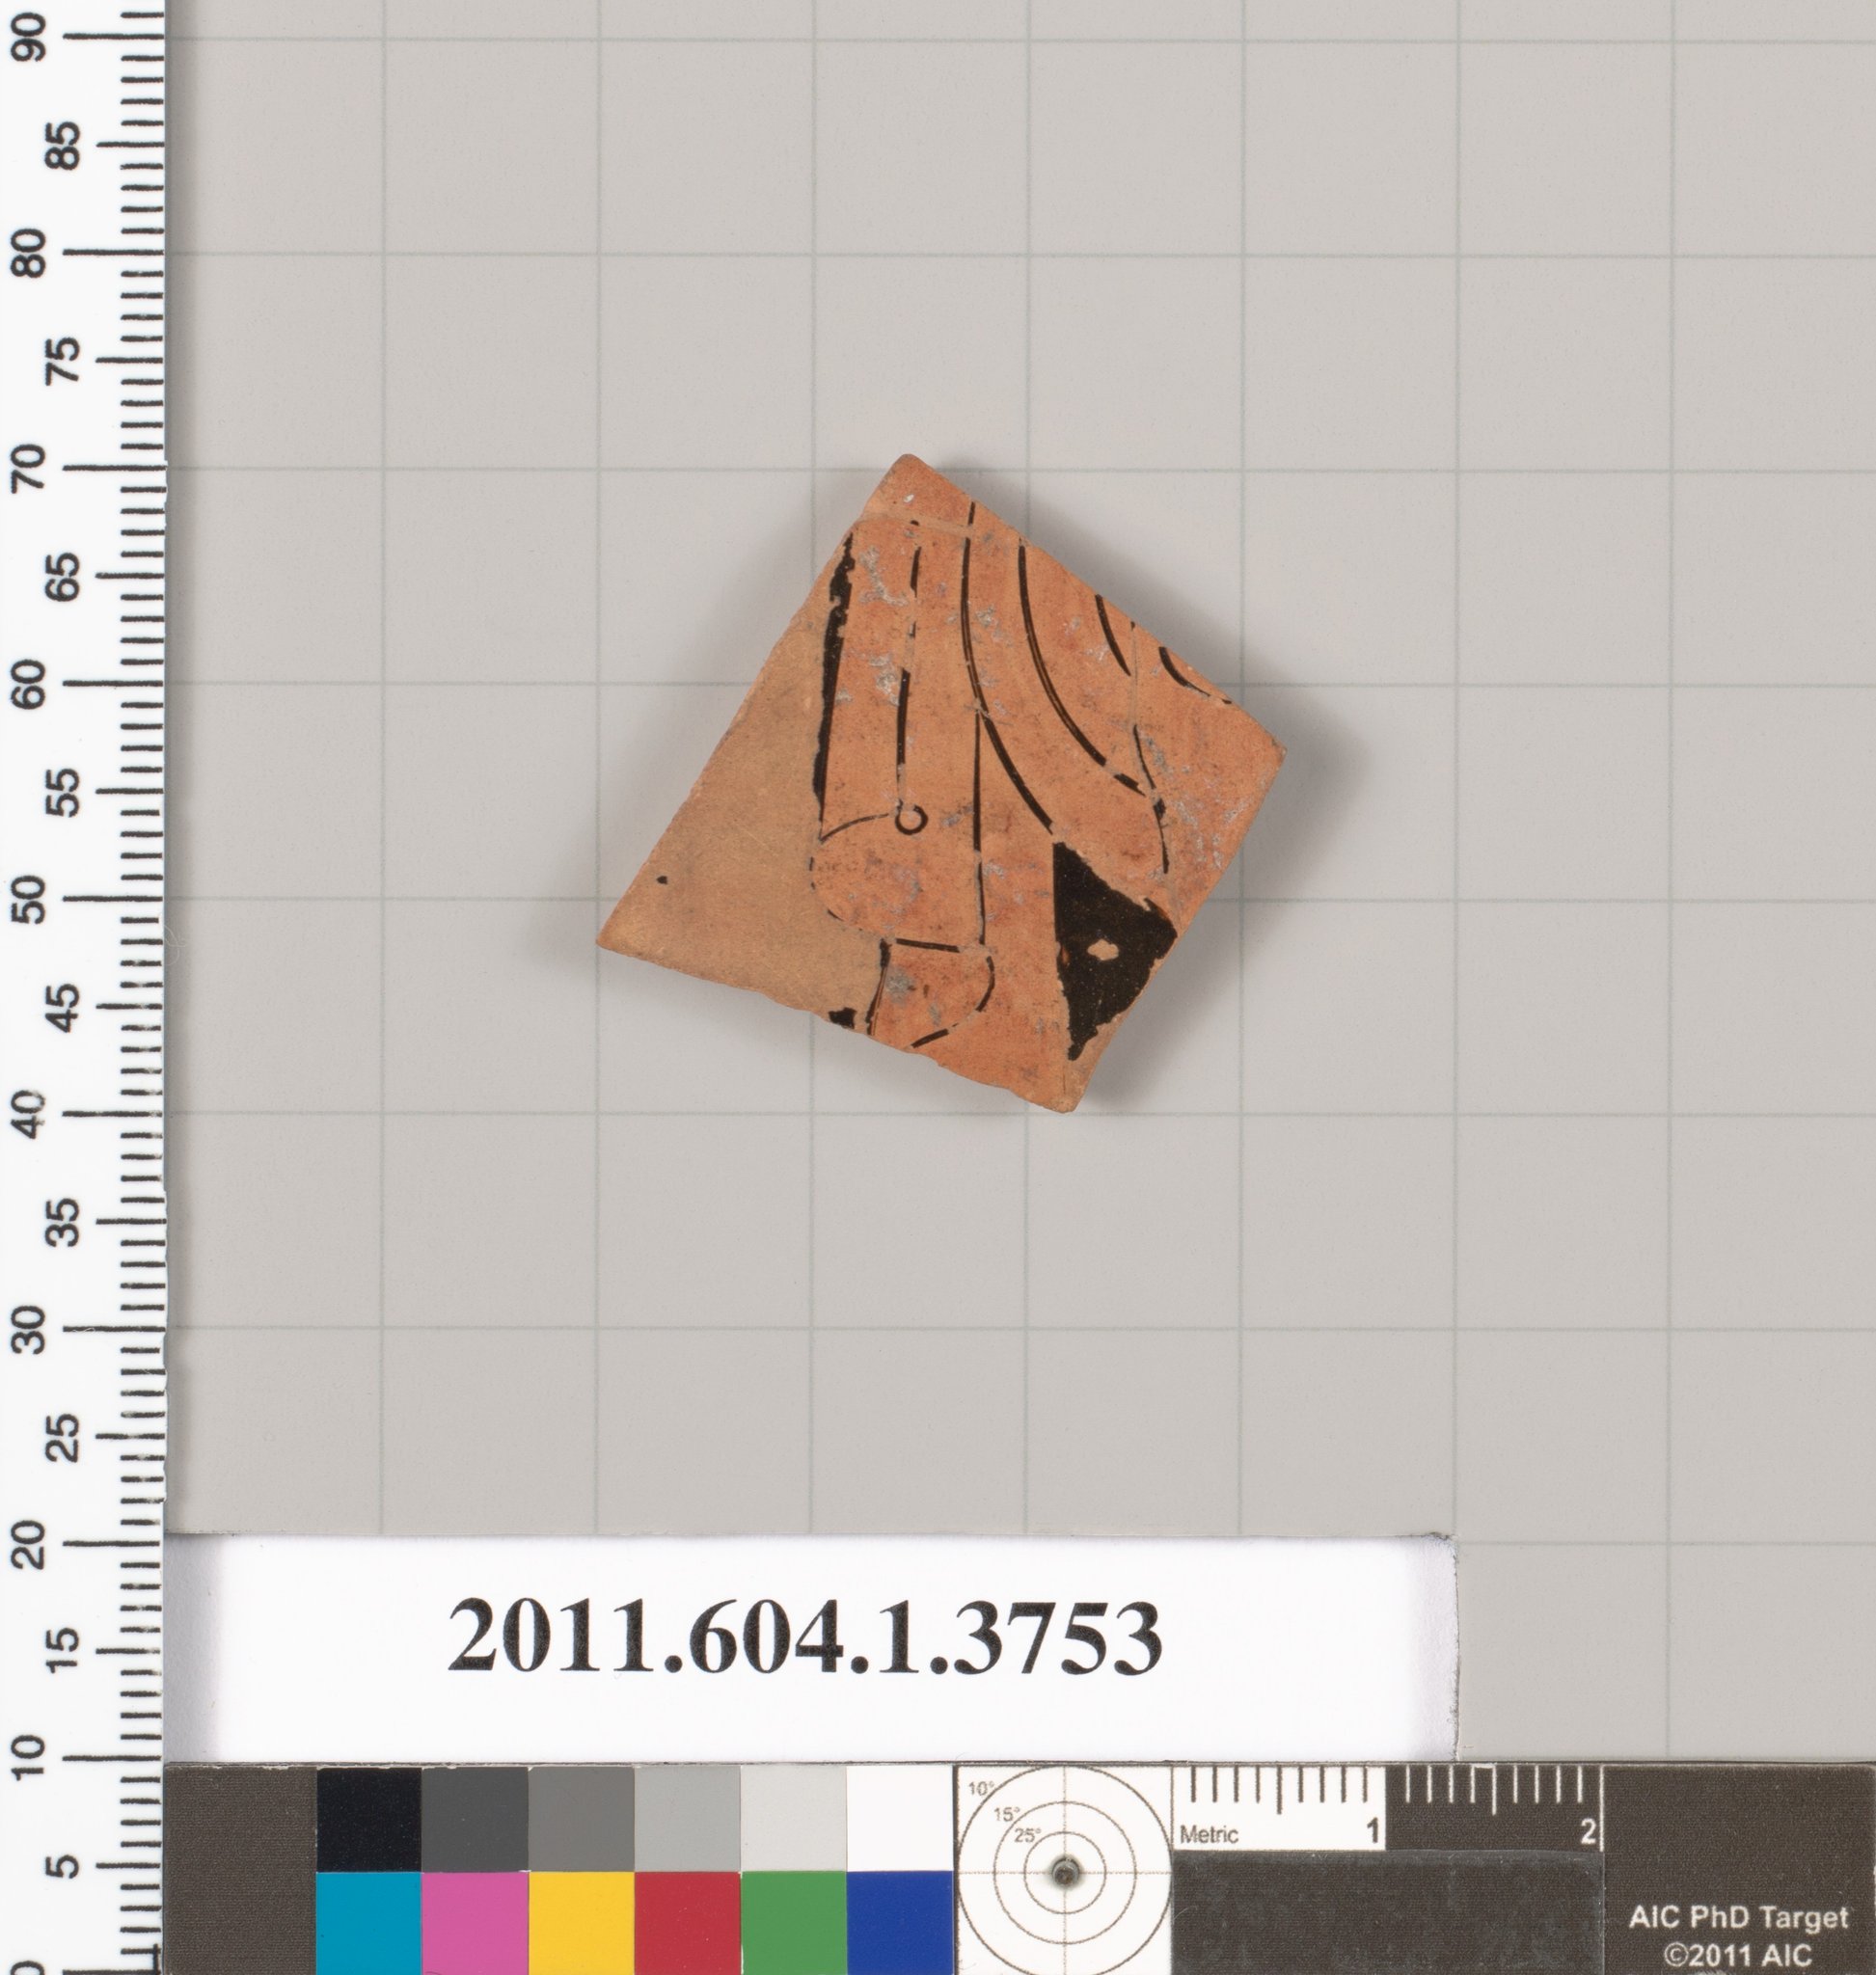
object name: kylix fragment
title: Terracotta fragment of a kylix (drinking cup)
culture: greek, attic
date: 500-470 BCE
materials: terracotta